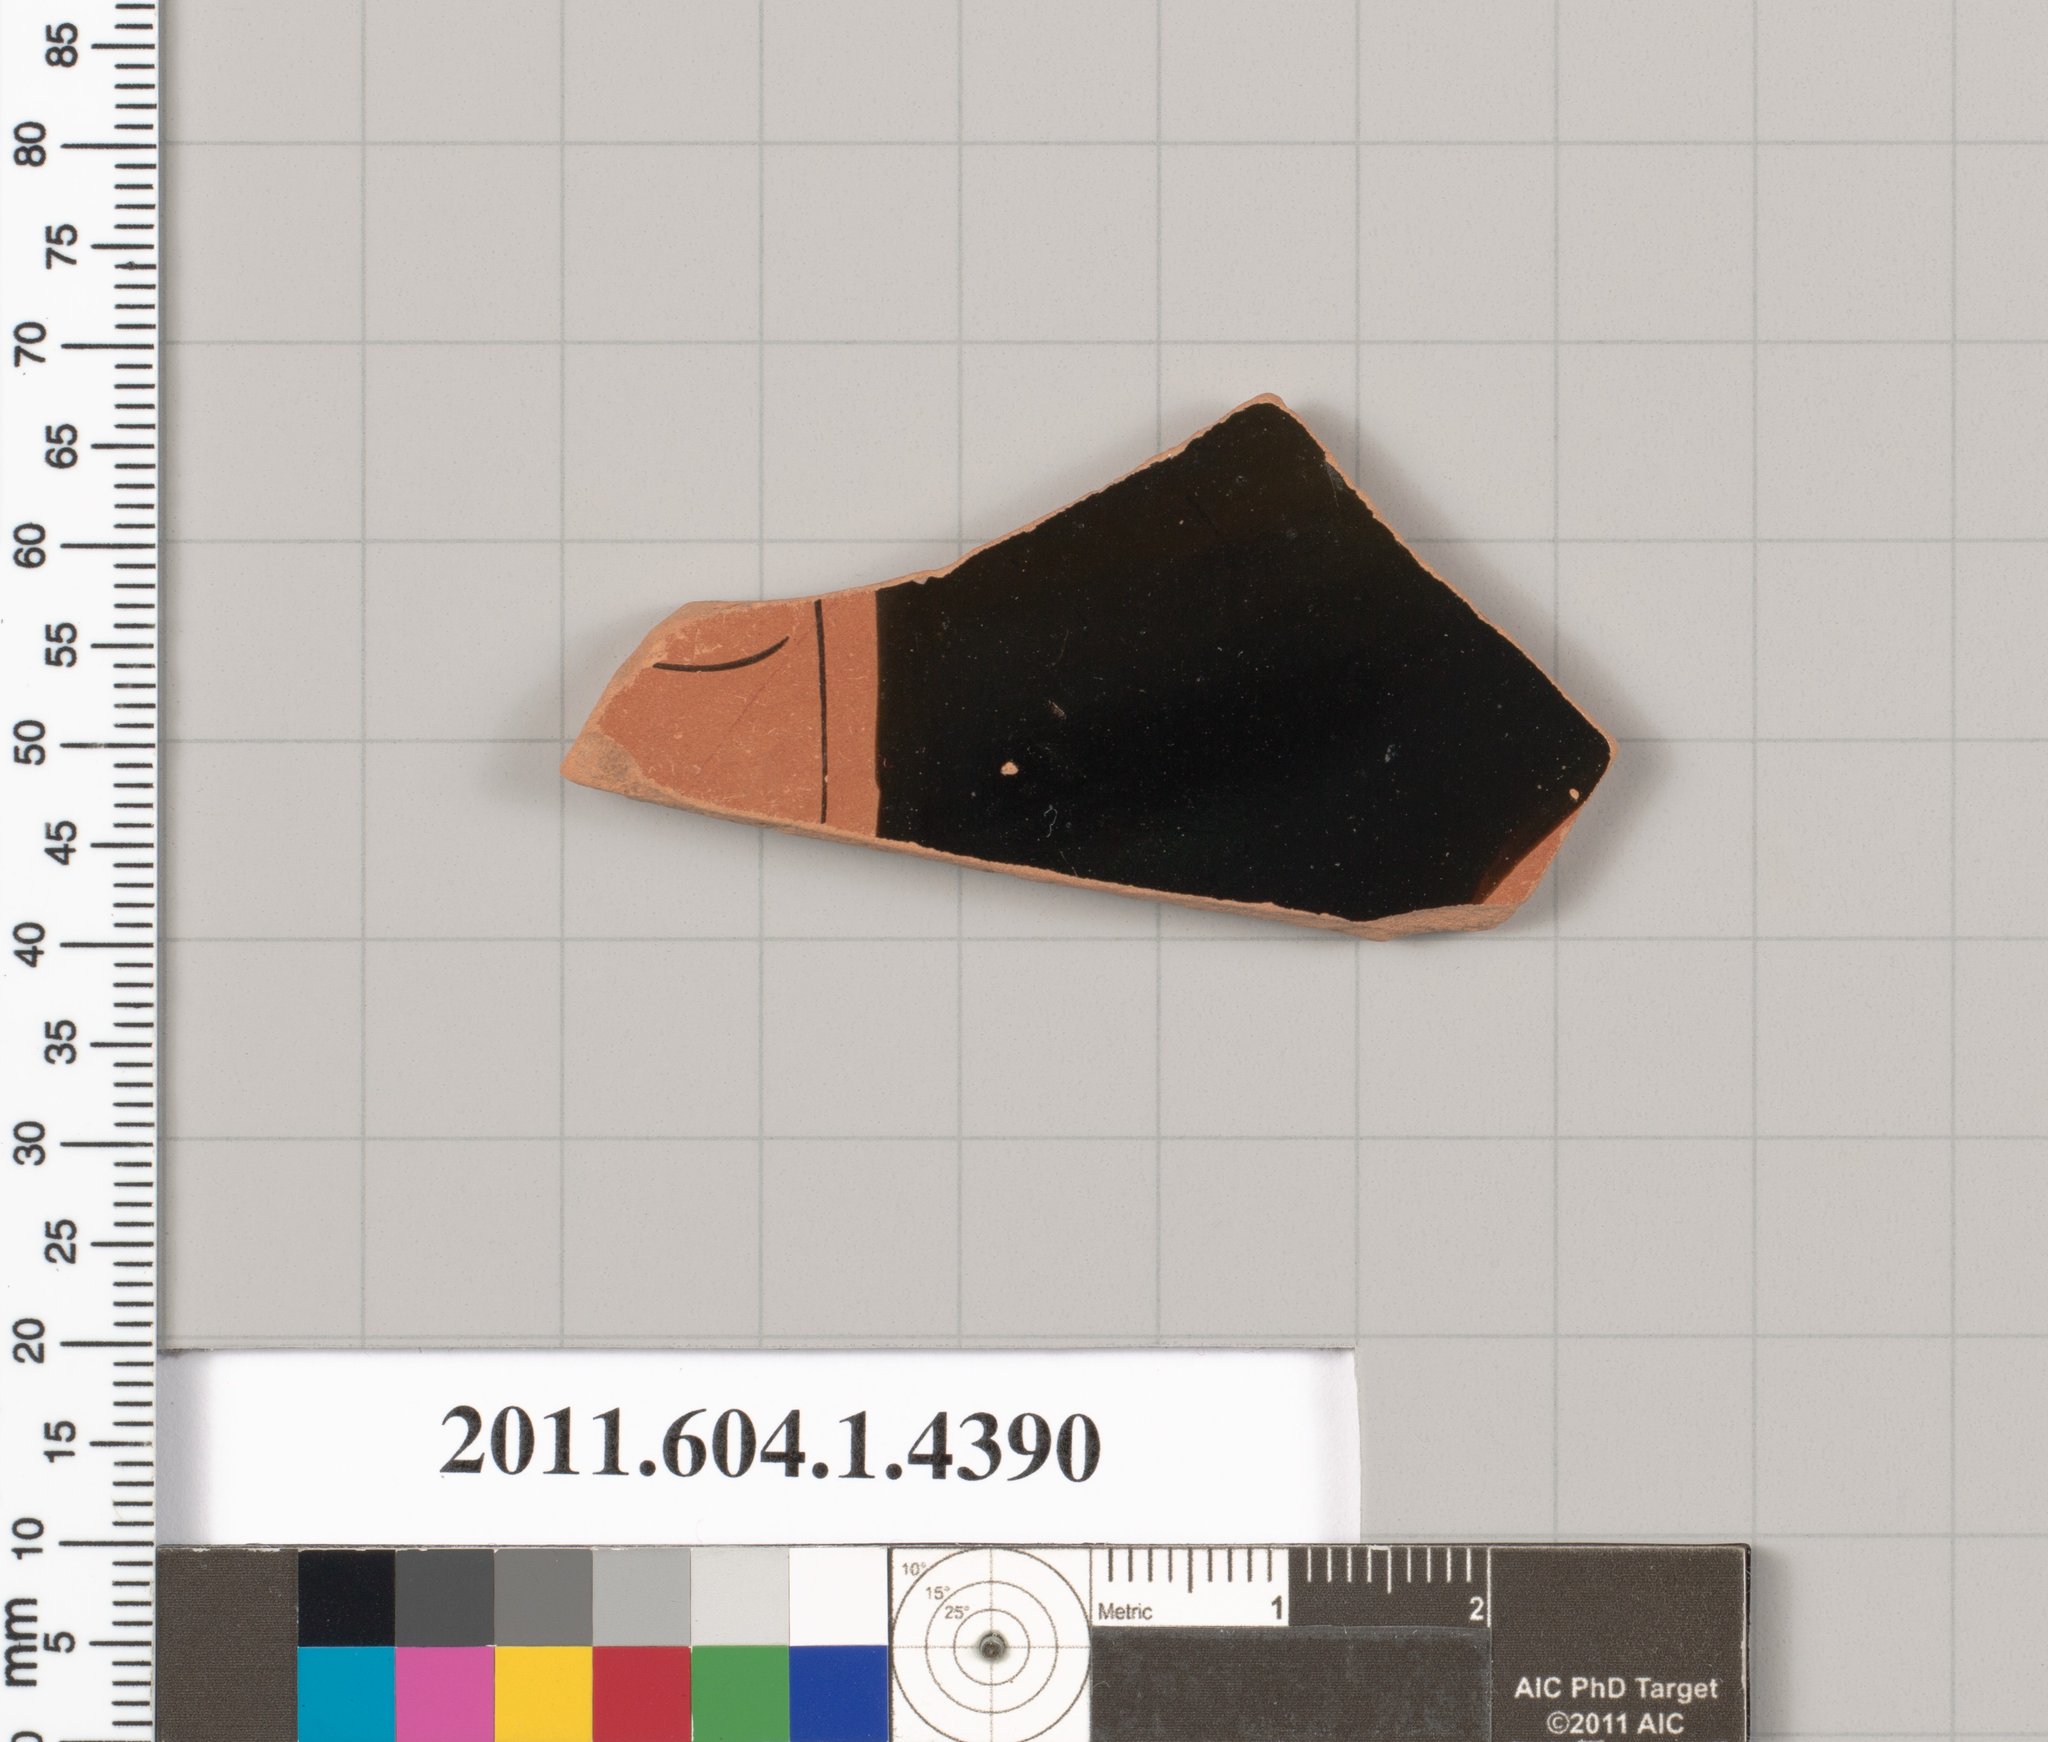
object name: kylix fragment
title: Terracotta fragment of a kylix (drinking cup)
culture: greek, attic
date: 475-451 BCE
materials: terracotta